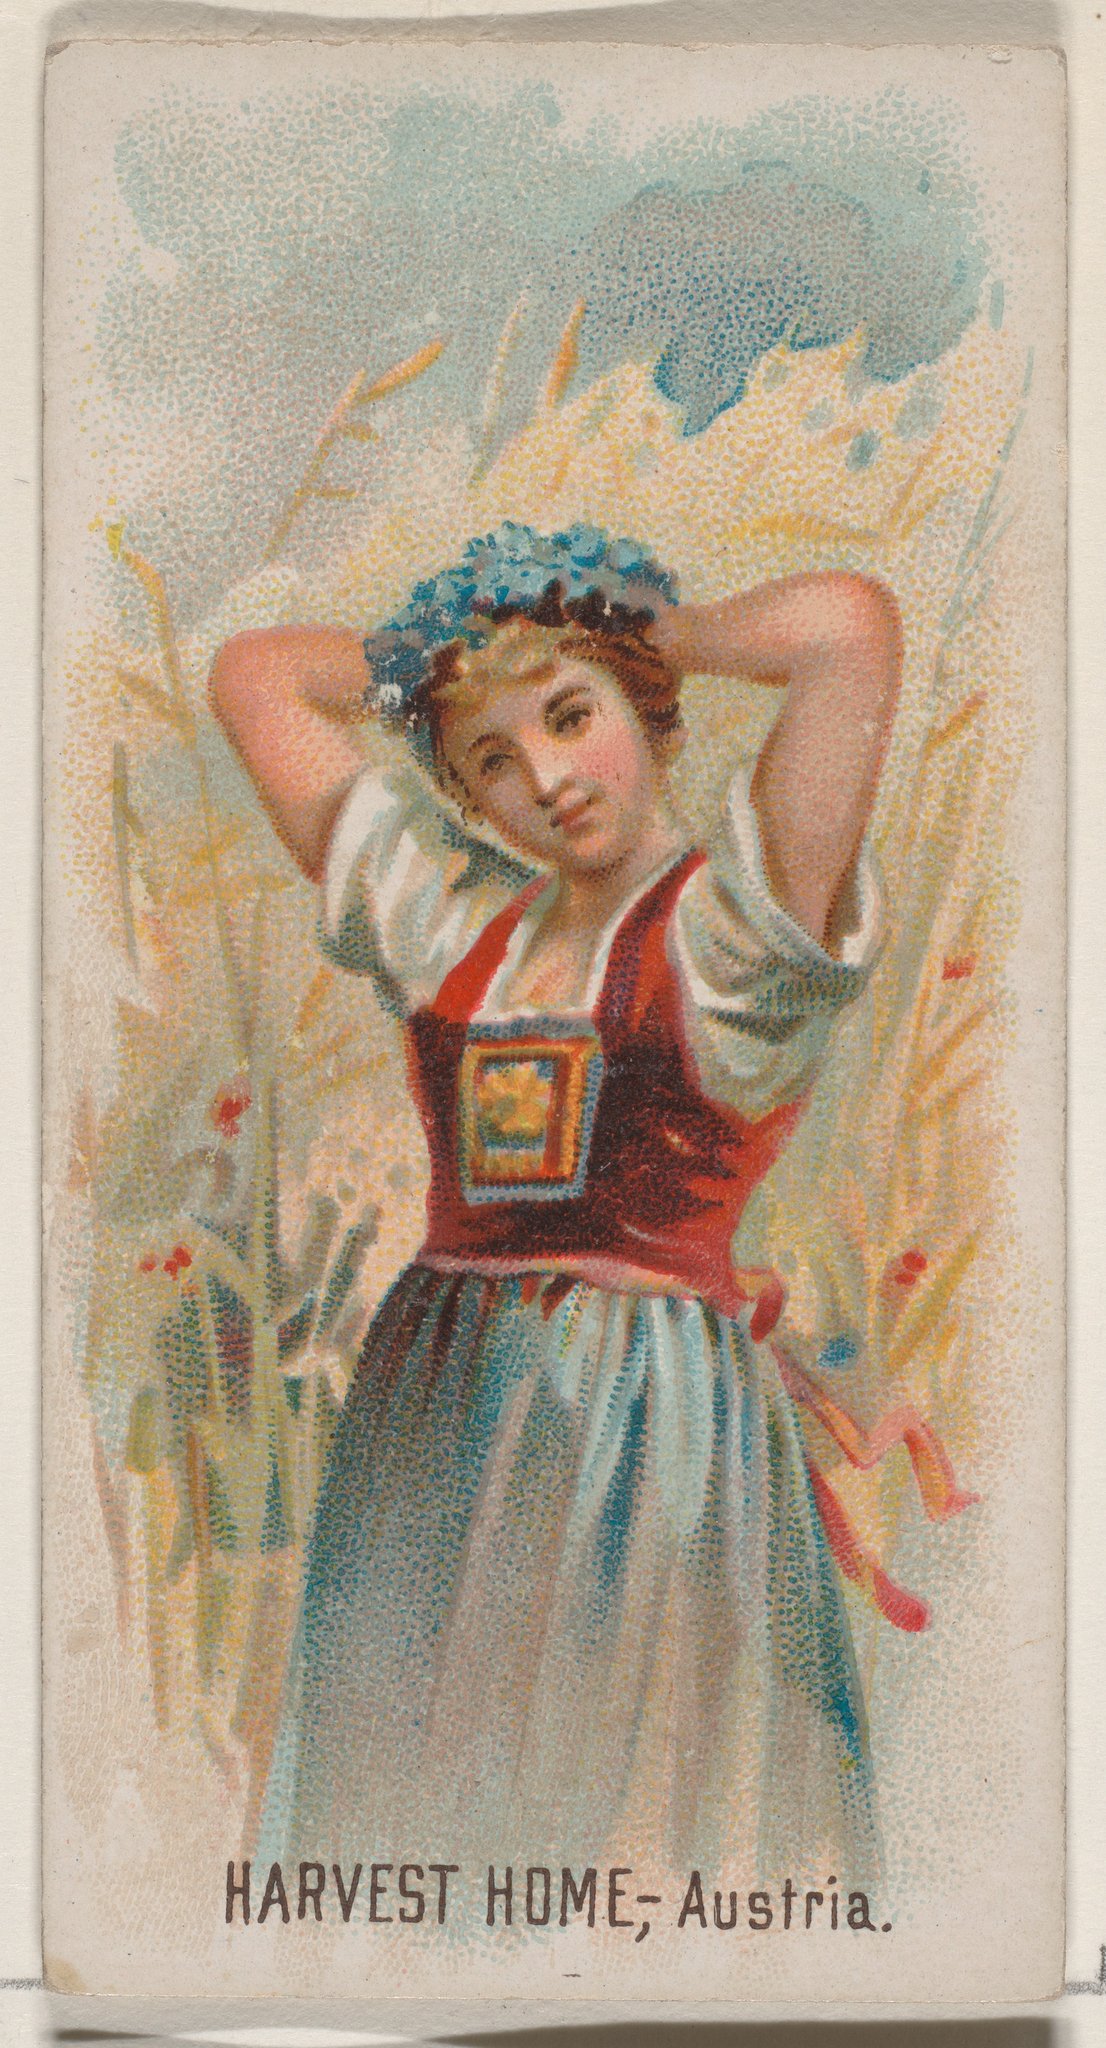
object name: print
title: Harvest Home, Austria, from the Holidays series (N80) for Duke brand cigarettes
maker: w. duke, sons & co.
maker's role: publisher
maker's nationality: american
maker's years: 1870-1920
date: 1890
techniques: color lithograph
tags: women